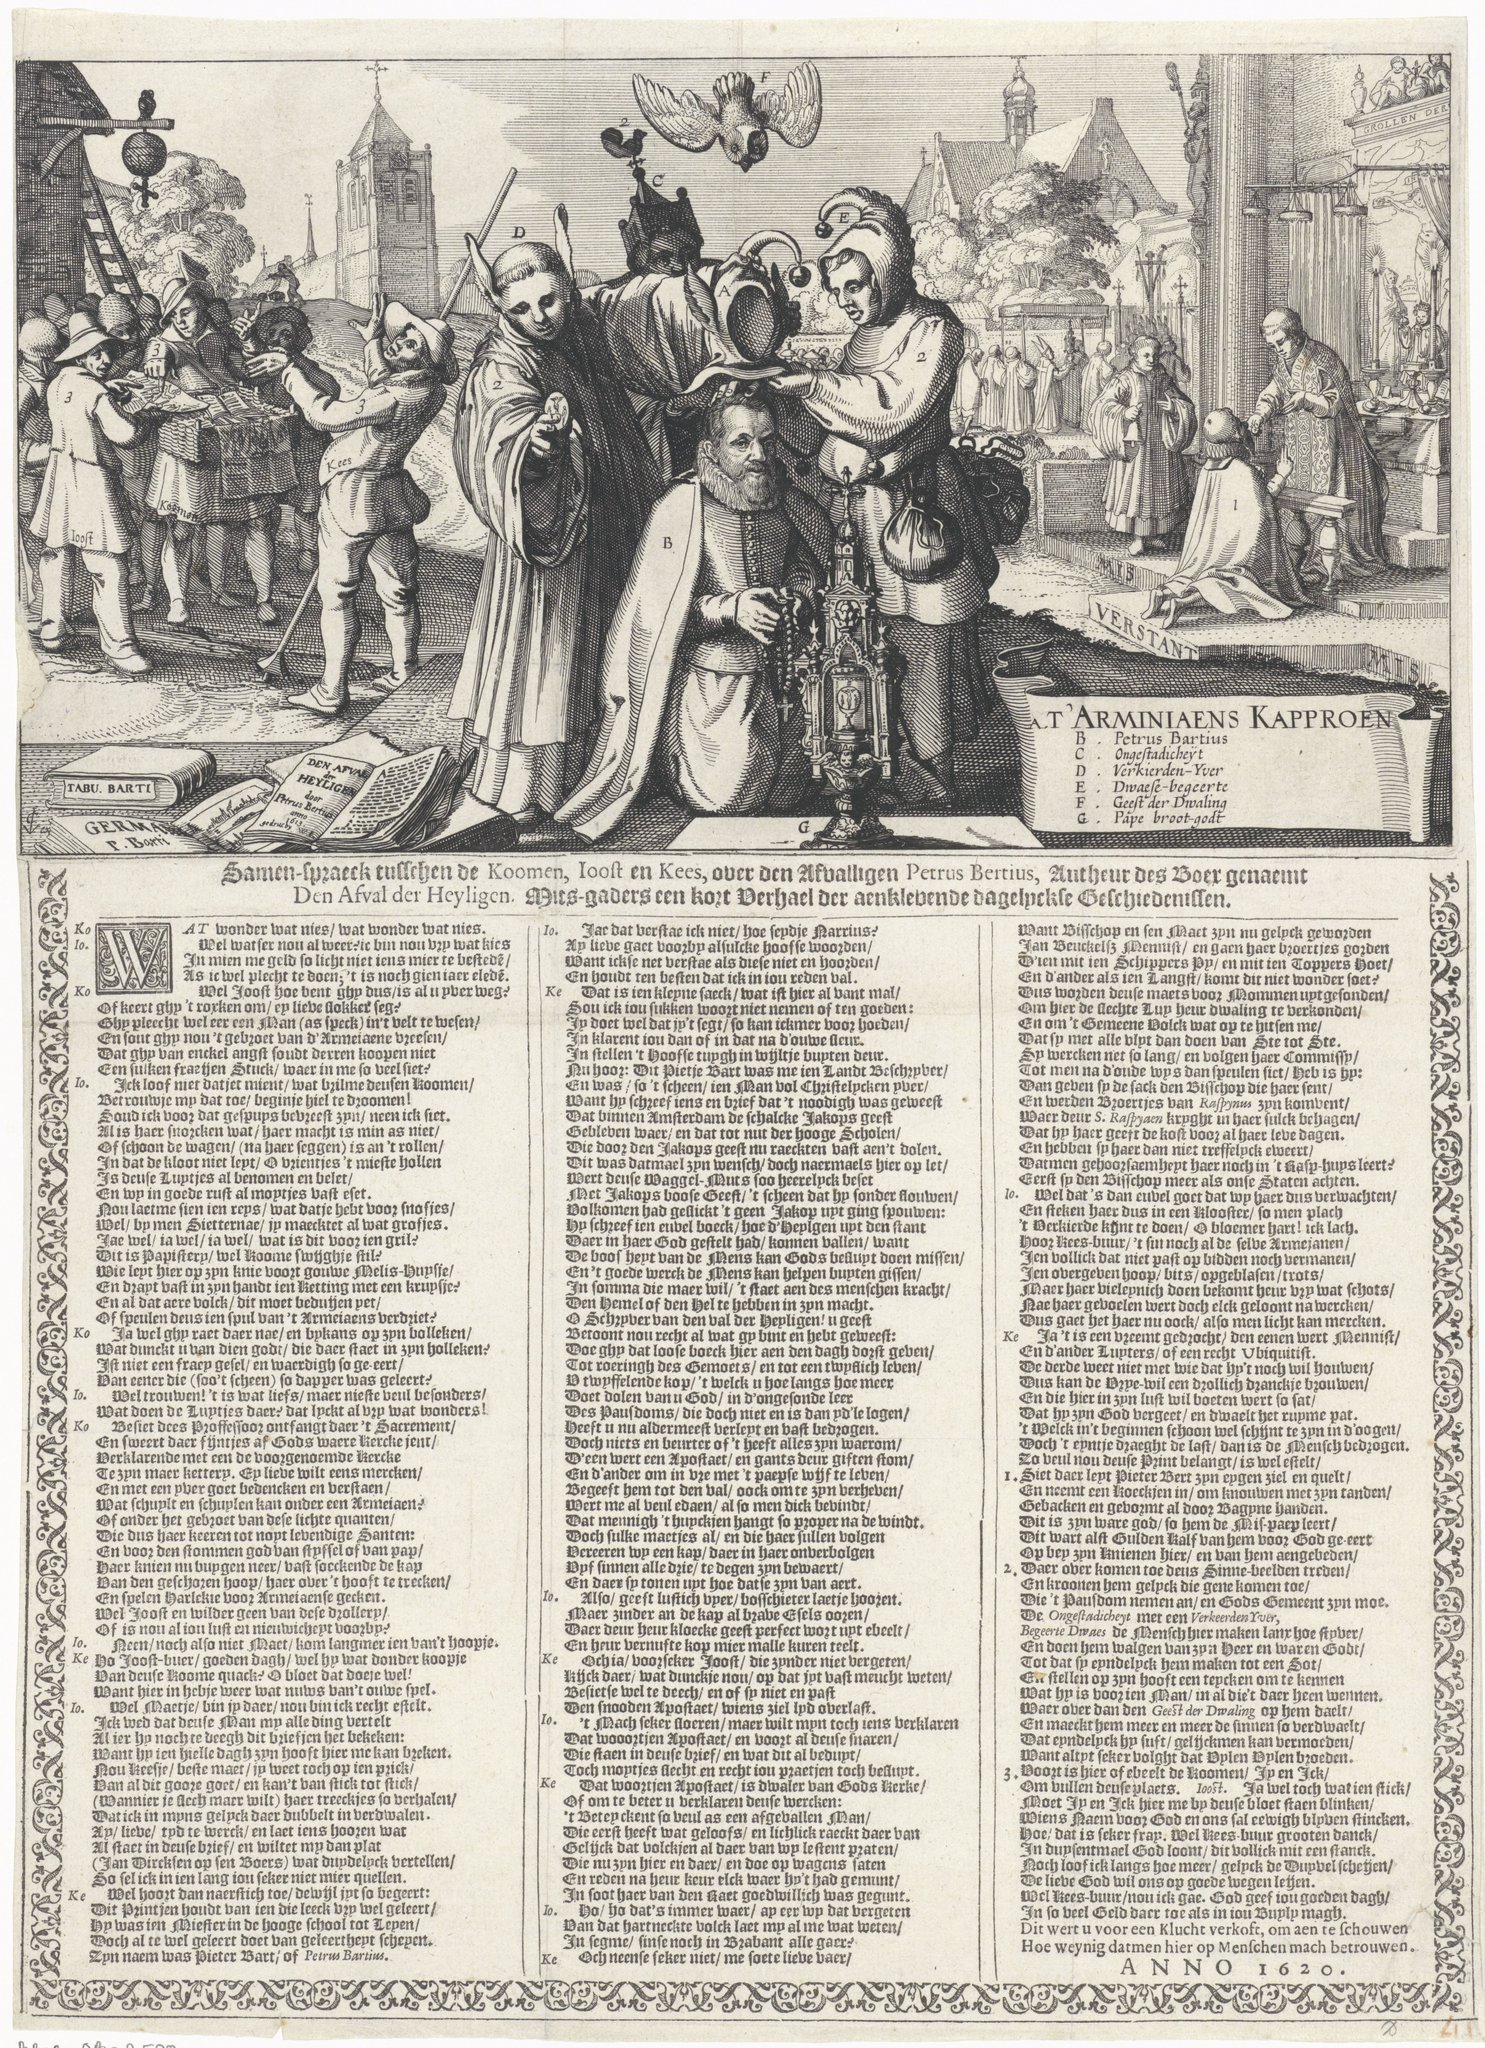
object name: cartoon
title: T' Arminiaens Kapproen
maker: claes jansz. visscher (ii)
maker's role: draughtsman, print maker, publisher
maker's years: 1586-1652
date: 1620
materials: paper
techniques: etching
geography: amsterdam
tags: paris, distributing pamphlets, 'consecratio', bread and wine changed into the body and blood of christ, fool's cap, pamphlet ~ printed matter, converts abjuring their former faith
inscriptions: address: ‘CIV ex.’, collector's mark: Lugt 240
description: In het midden op de voorgrond de Arminiaan Bartius, in gekielde houding voor een monstrans. Hem wordt de narrenkap opgezet door een monnik met ezelsoren (Verkeerde IJver) en een nar (Dwaze Begeerte). Boven zijn hoofd een uil (Geest der Dwaling). Linksachter drie straatventers met pamfletten. Rechtsachter een H. Communie voor een altaar. Linksvoor een stapel boeken van Bartius. Onder de voorstelling 203 regels tekst in boekdruk: Samespraeck tusschen...mach betrouwen. ANNO 1620.